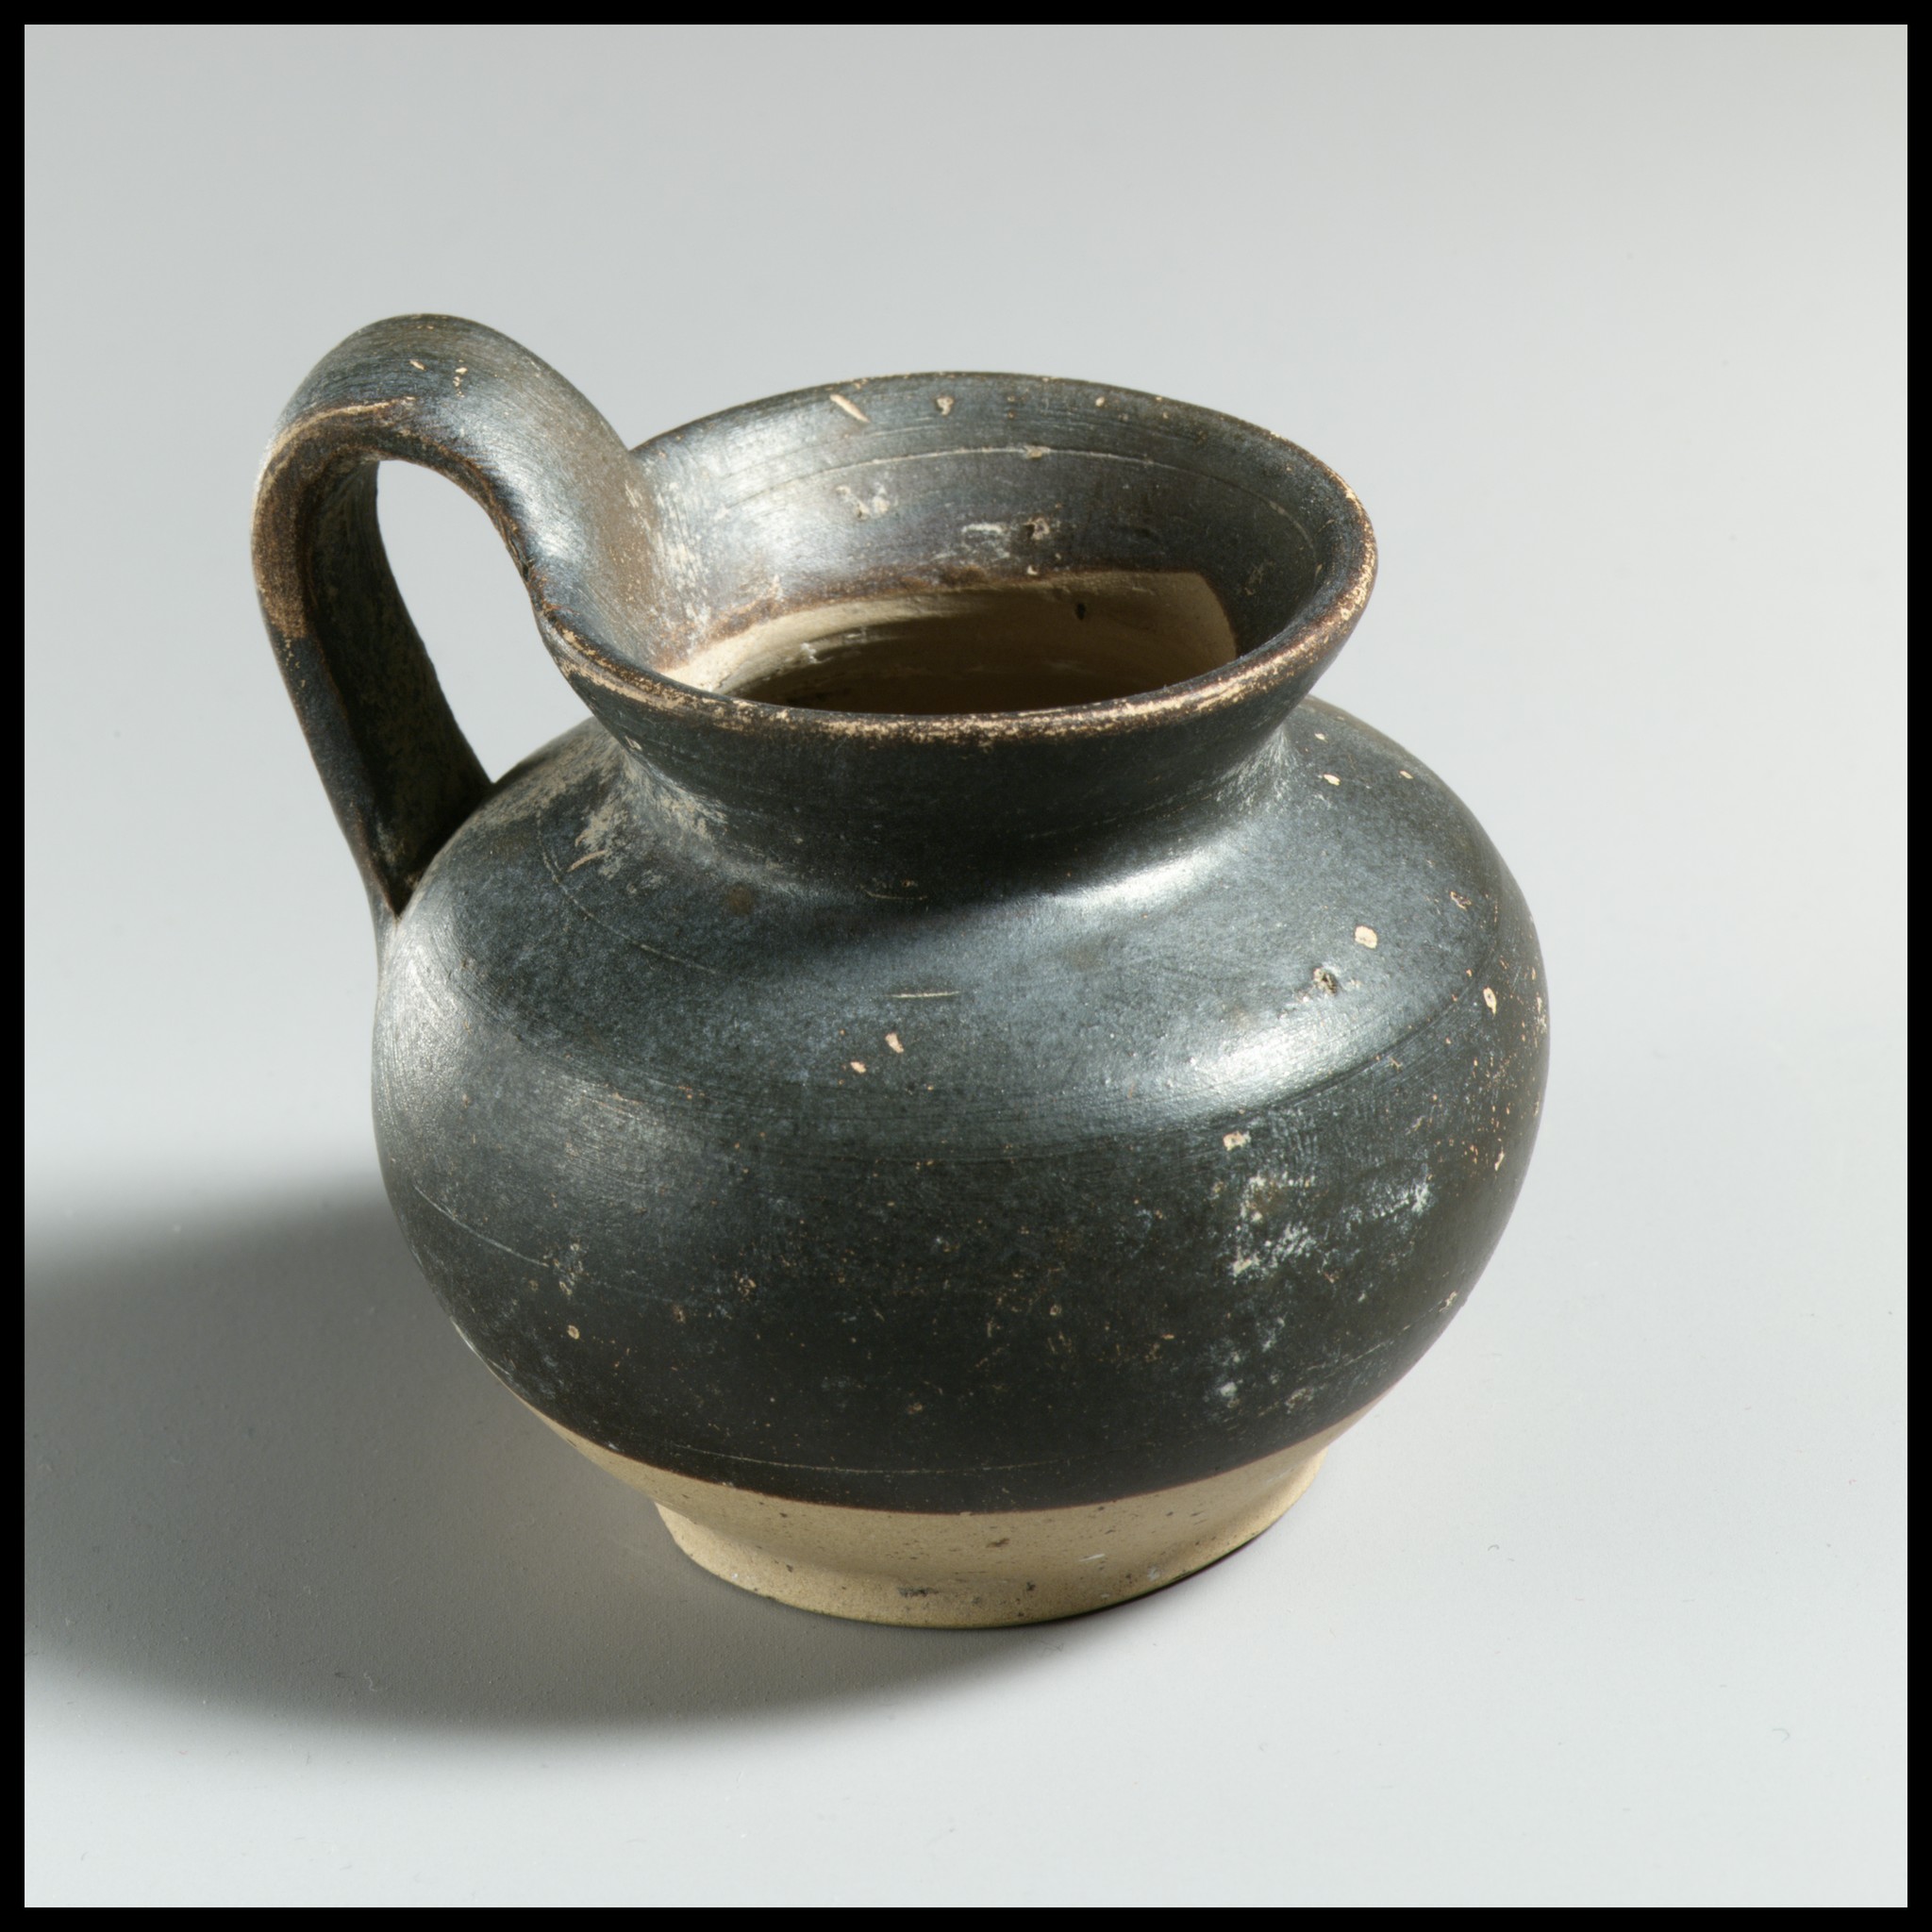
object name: jug, miniature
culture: italic-native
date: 400-301 BCE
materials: terracotta